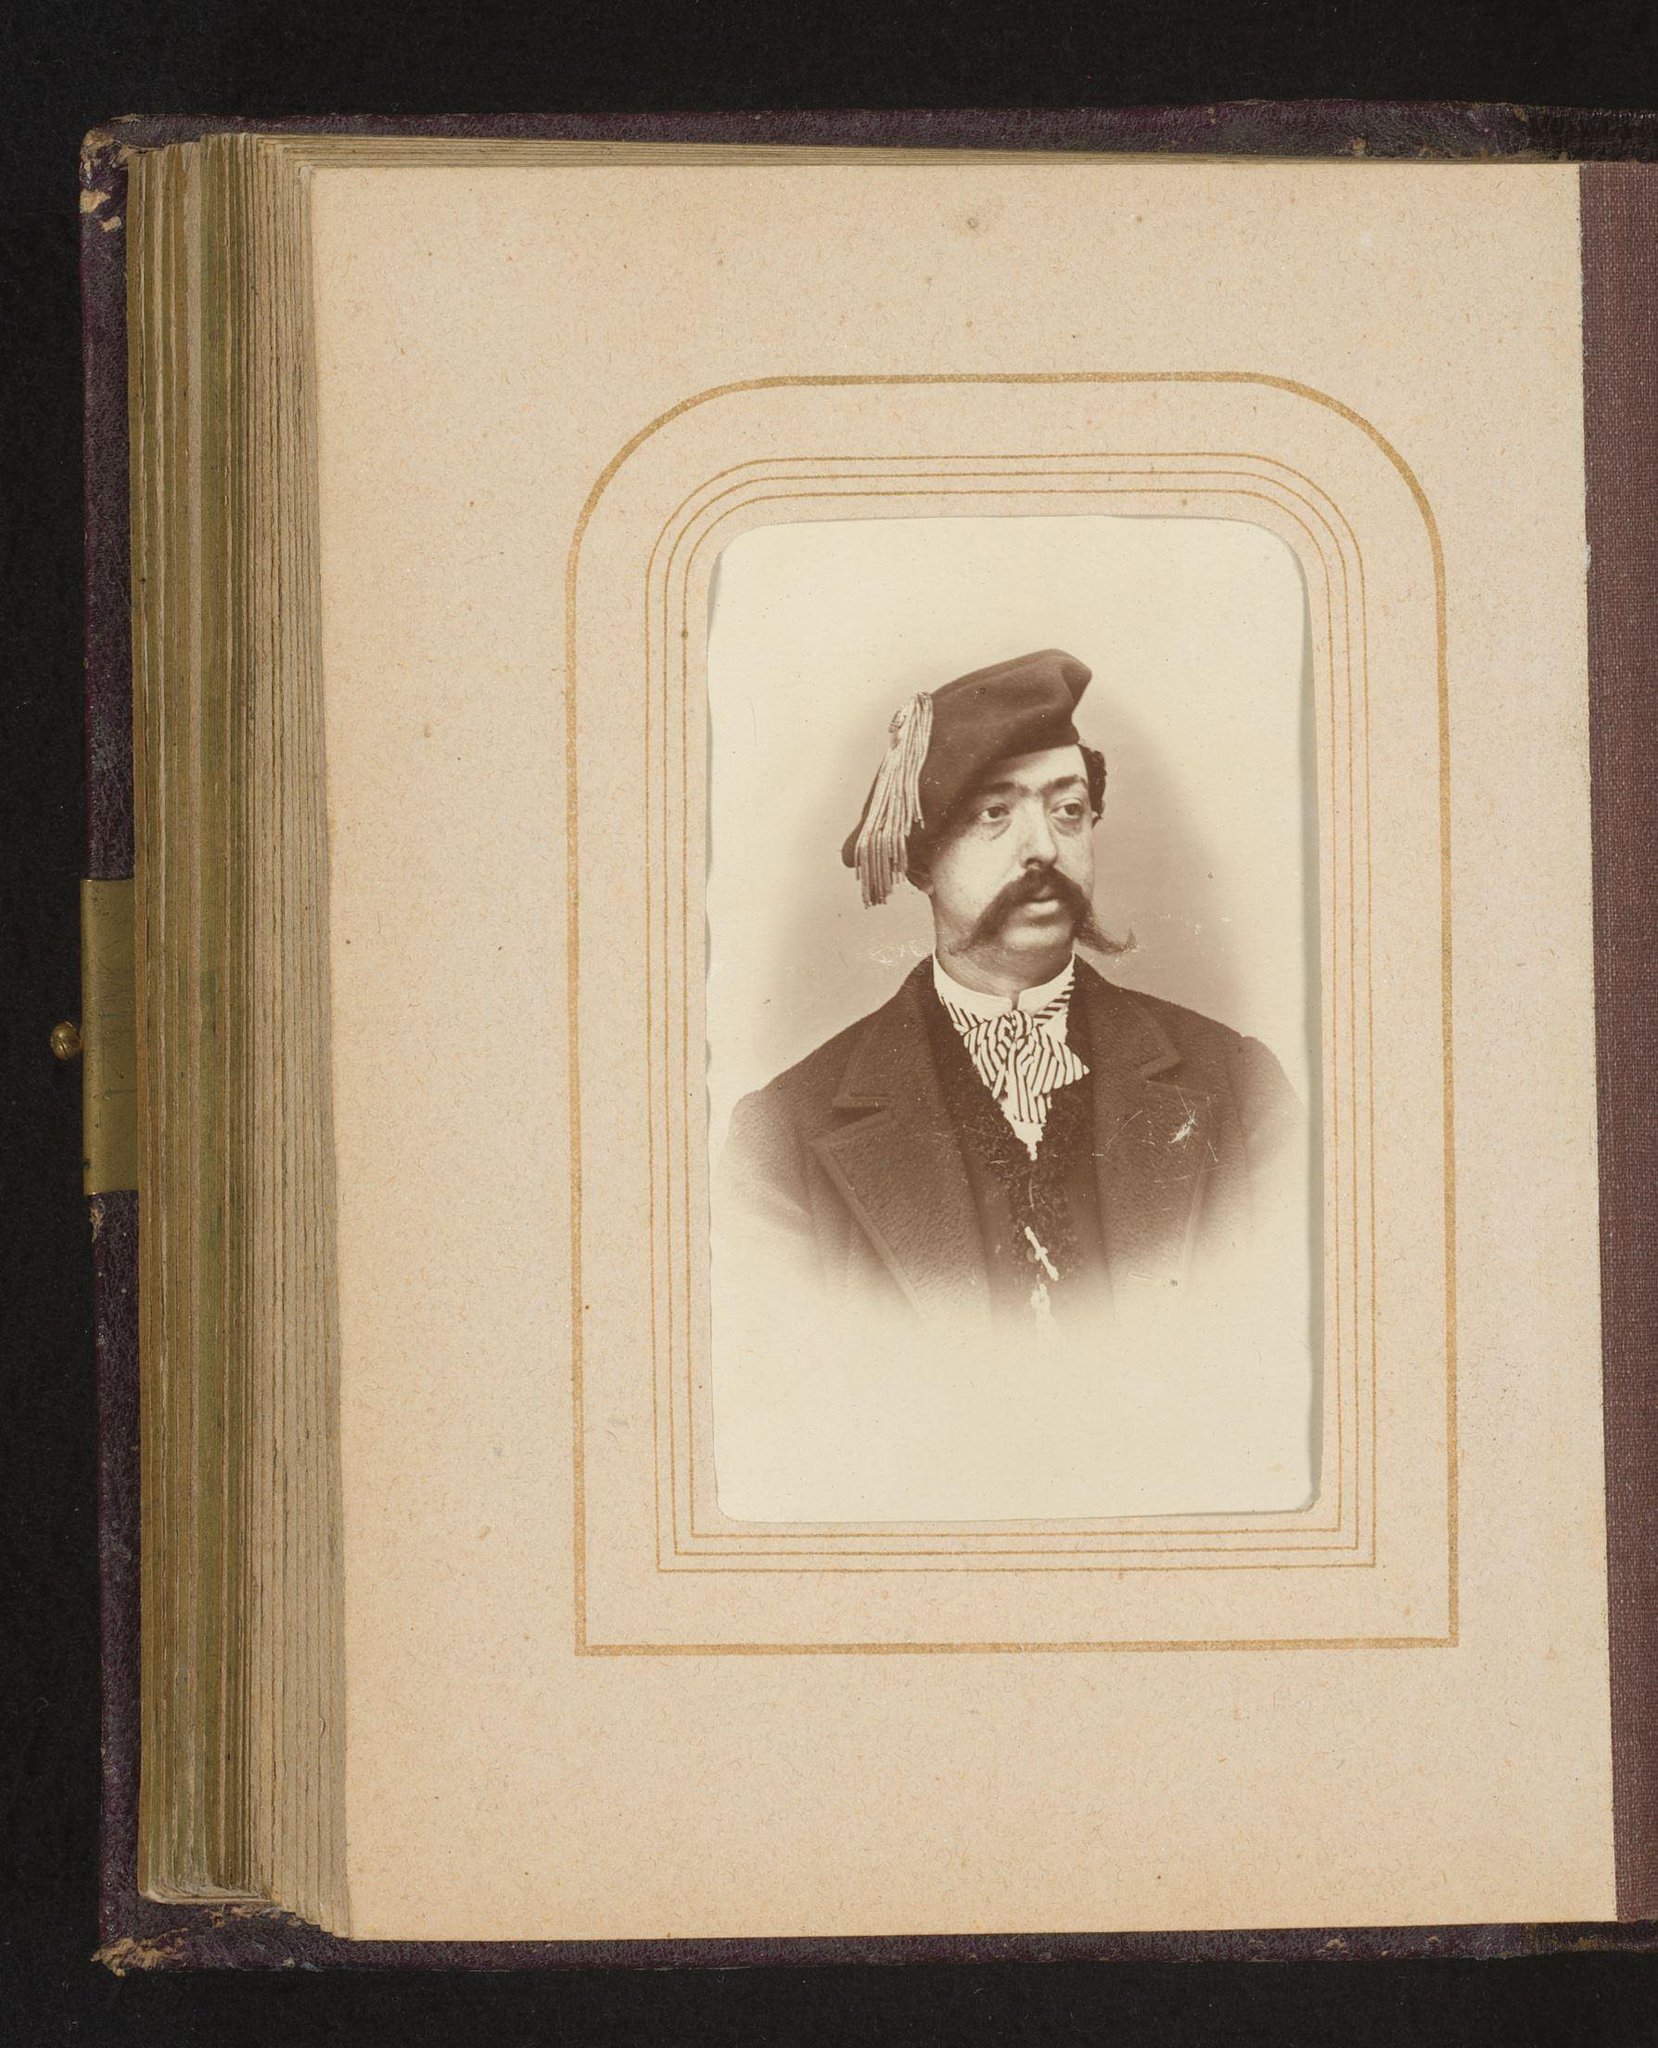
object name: photograph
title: Portret van een man met snor en pet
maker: Anonymous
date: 1860-1900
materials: cardboard, photographic support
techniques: albumen print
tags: moustache, historical persons, head-gear: hat